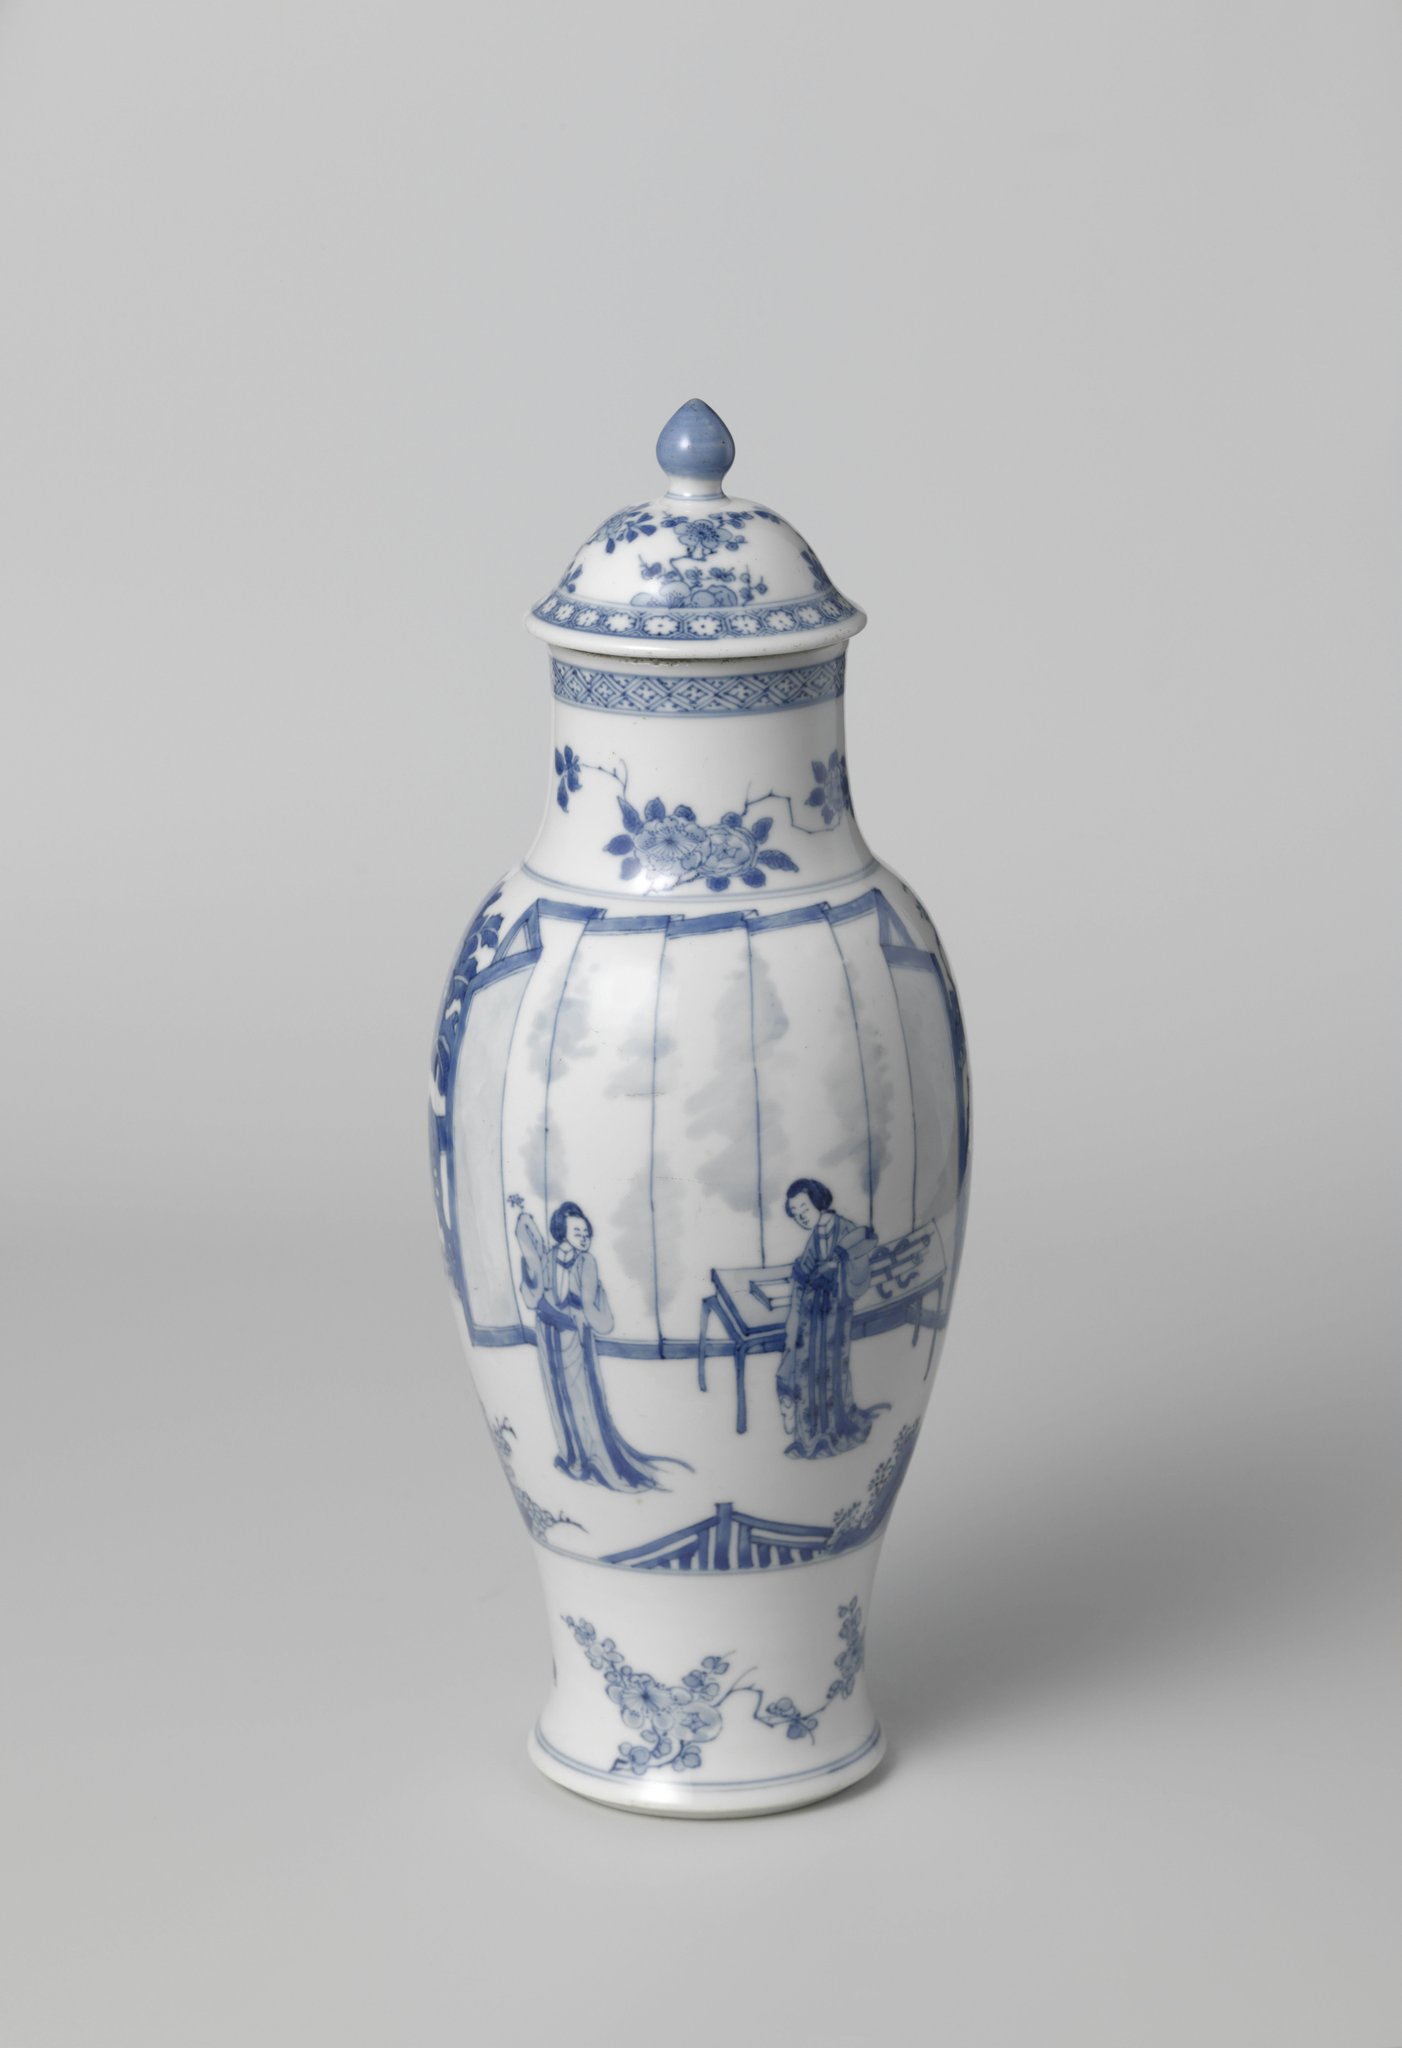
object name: vase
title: Baluster covered vase with women in a fenced garden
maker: Anonymous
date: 1700-1724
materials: cobalt, glaze, paint, porcelain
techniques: firing, turning, vitrification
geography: china